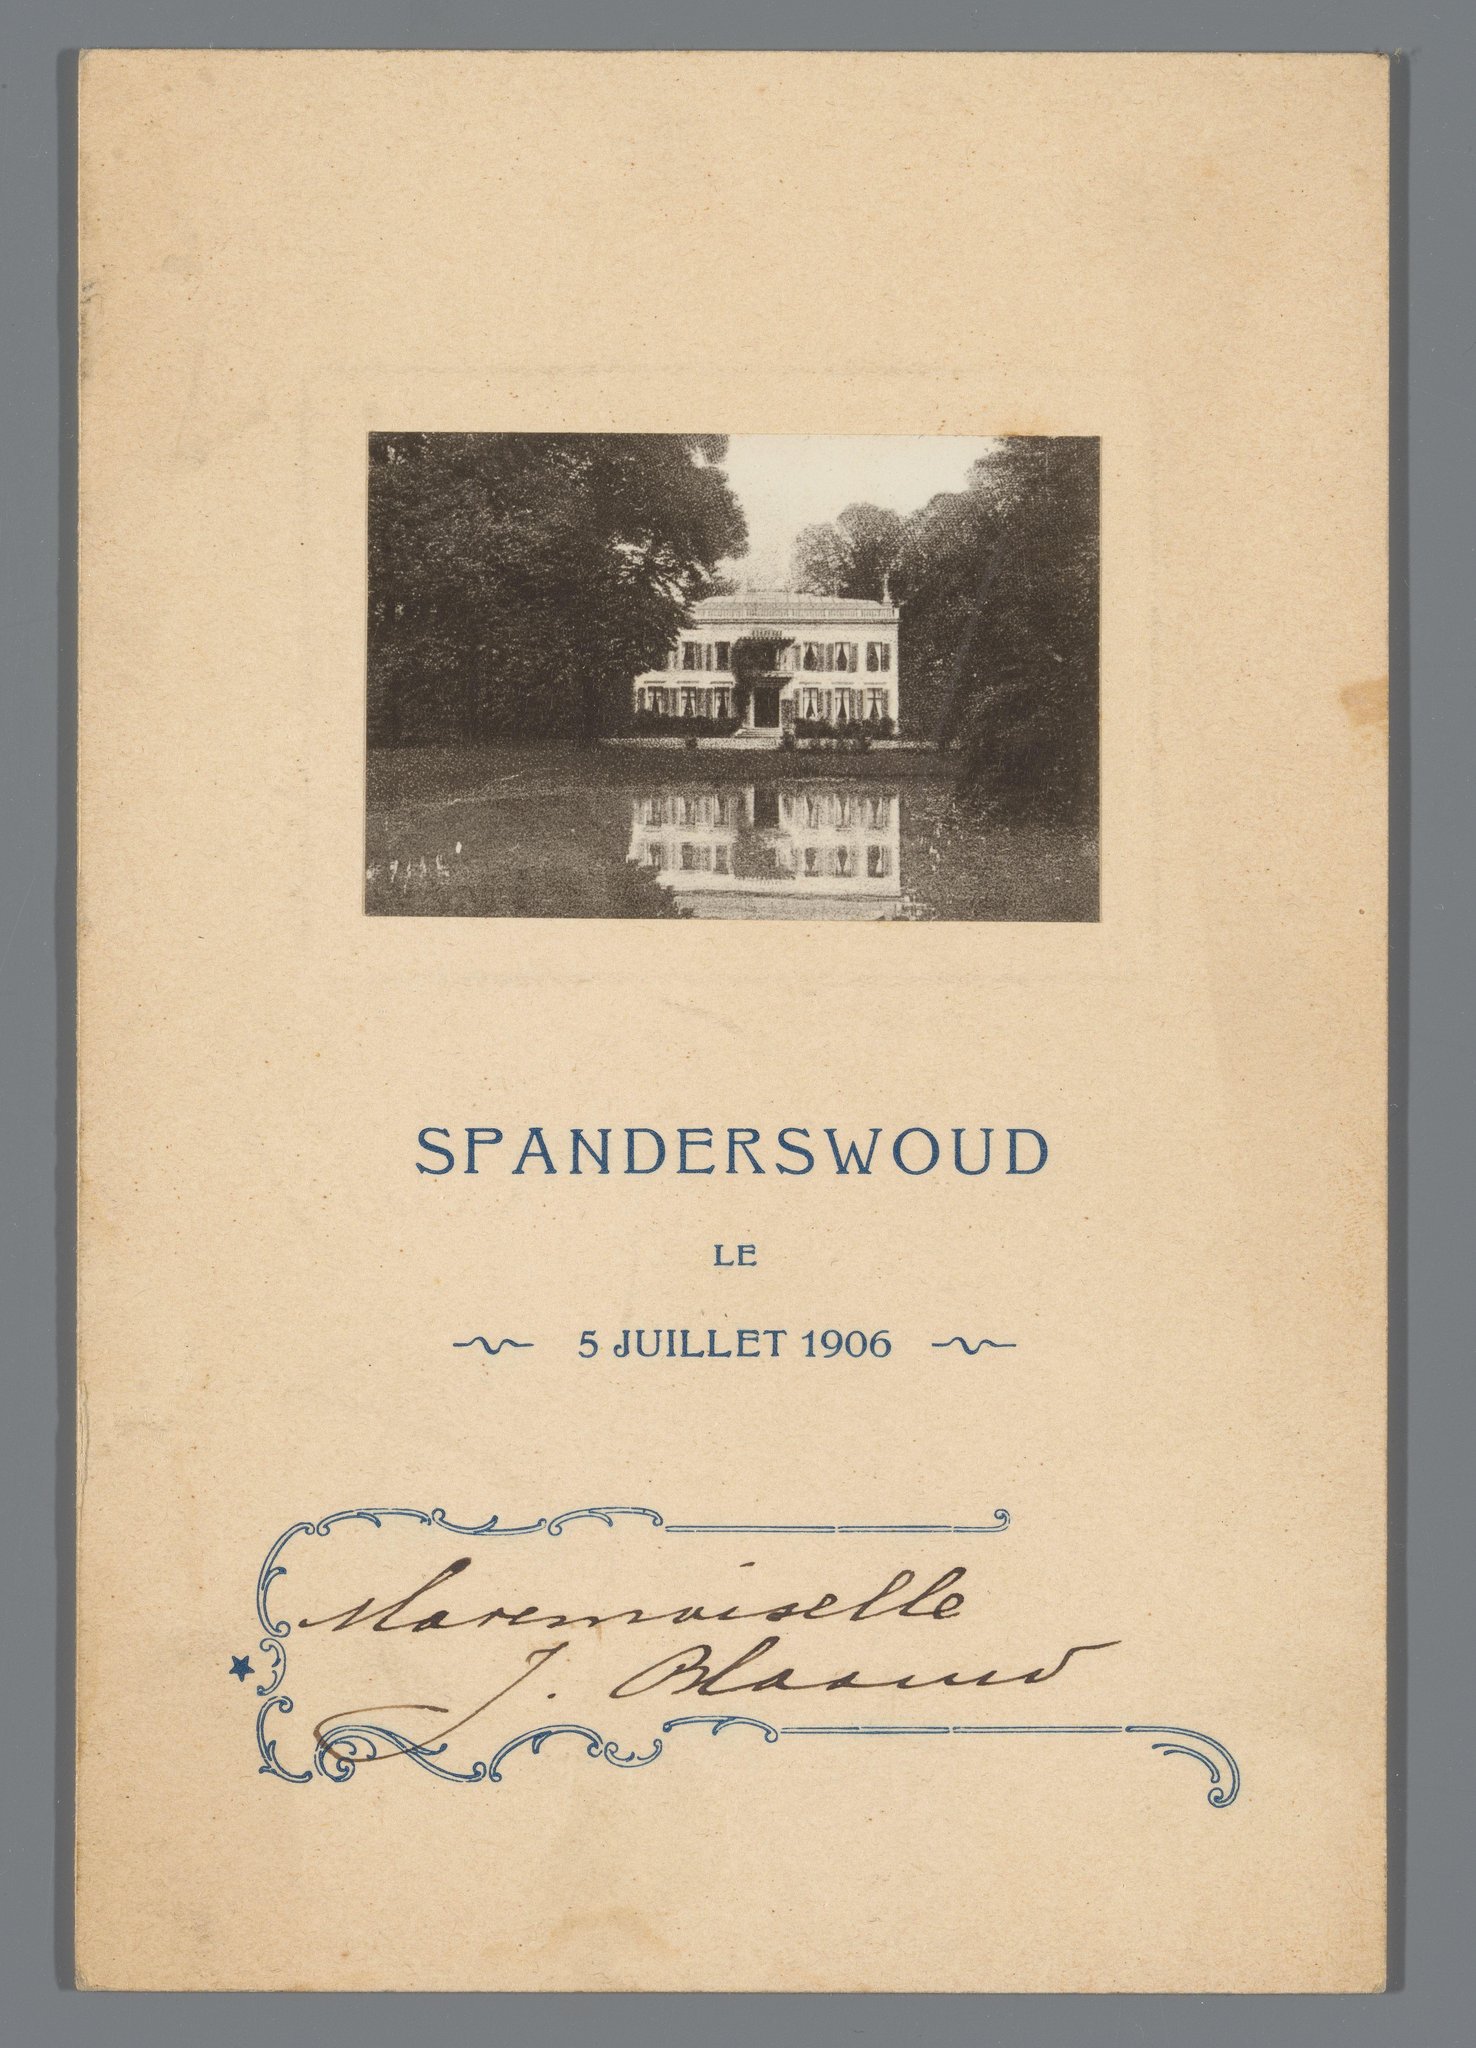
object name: menu, menukaart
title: Menukaart voor een diner gegeven door/ voor mevrouw J. Blaauw te Spanderswoud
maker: Anonymous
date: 1906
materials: ink, paper, pencil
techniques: letterpress printing, pen, photolithography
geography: spanderswoud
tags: country-house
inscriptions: inscription: ‘Mademoiselle/ J. Blaauw’, inscription: ‘Menu. (...)’, inscription: ‘Spanderswoud/ le/ 5 Juillet 1906’, inscription